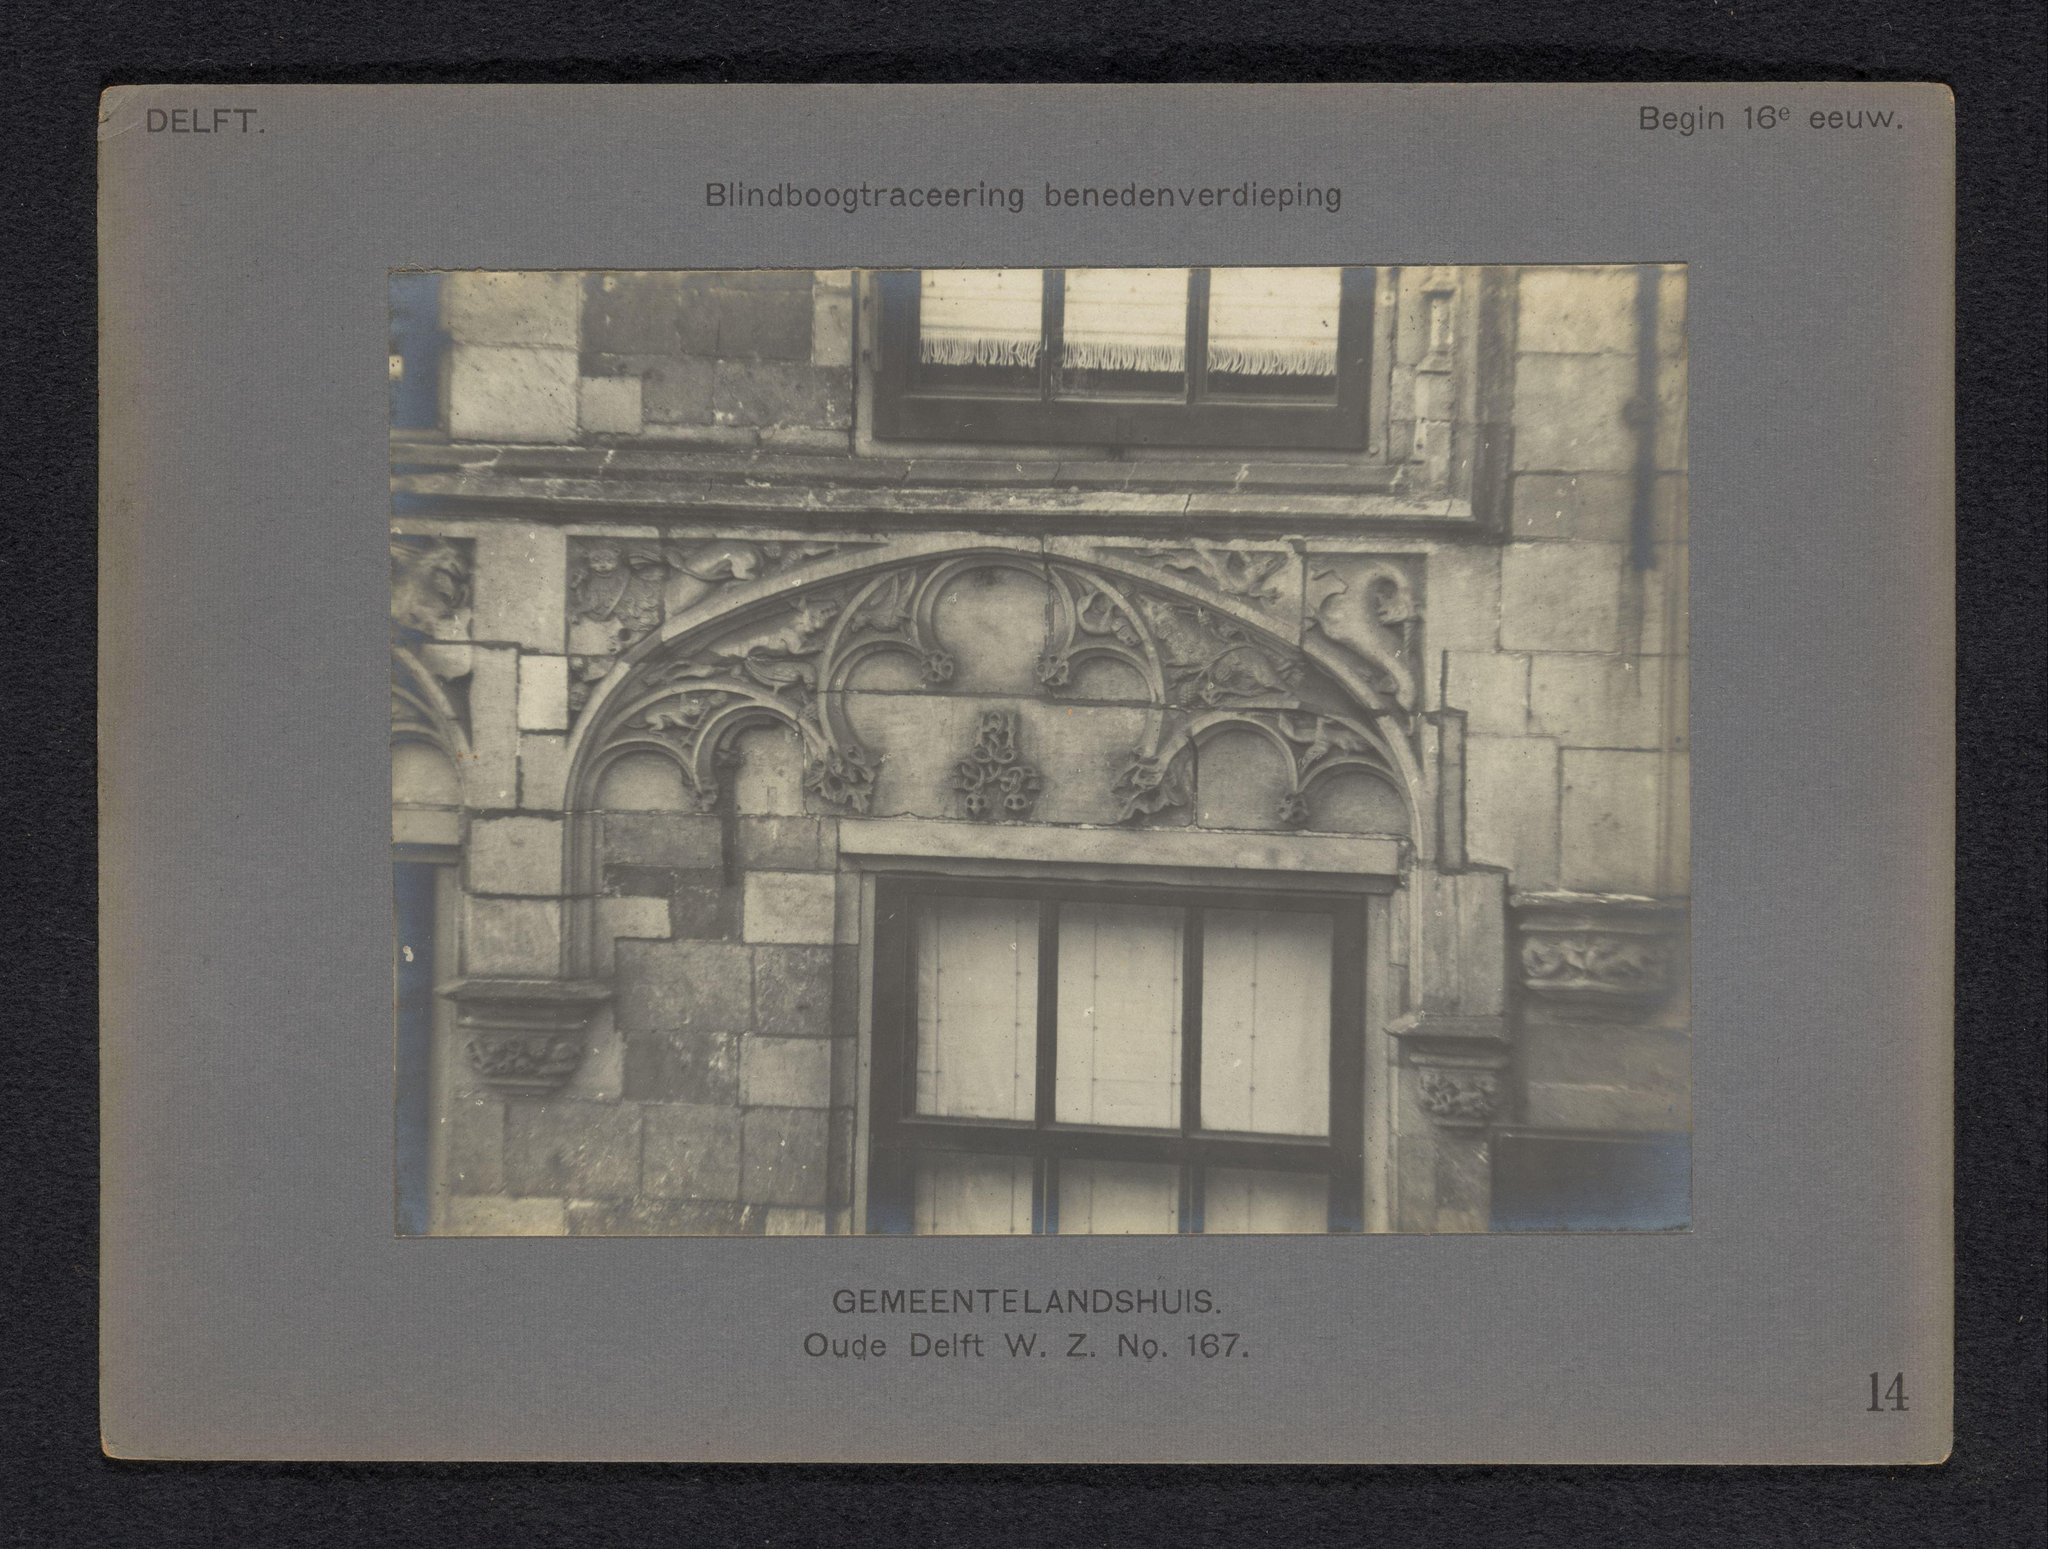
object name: photograph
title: Ramen van het Gemeenlandshuis aan de Oude Delft in Delft gedecoreerd met bogen en bladmotieven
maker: Anonymous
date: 1900-1904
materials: cardboard, photographic support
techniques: gelatin silver print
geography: delft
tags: closed window, ornament derived from plant forms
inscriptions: number: ‘14’, inscription: ‘Het recht van reproductie dezer photo's wordt door den Uitgever voorbehouden.’, inscription: ‘Delft. Begin 16e eeuw.’